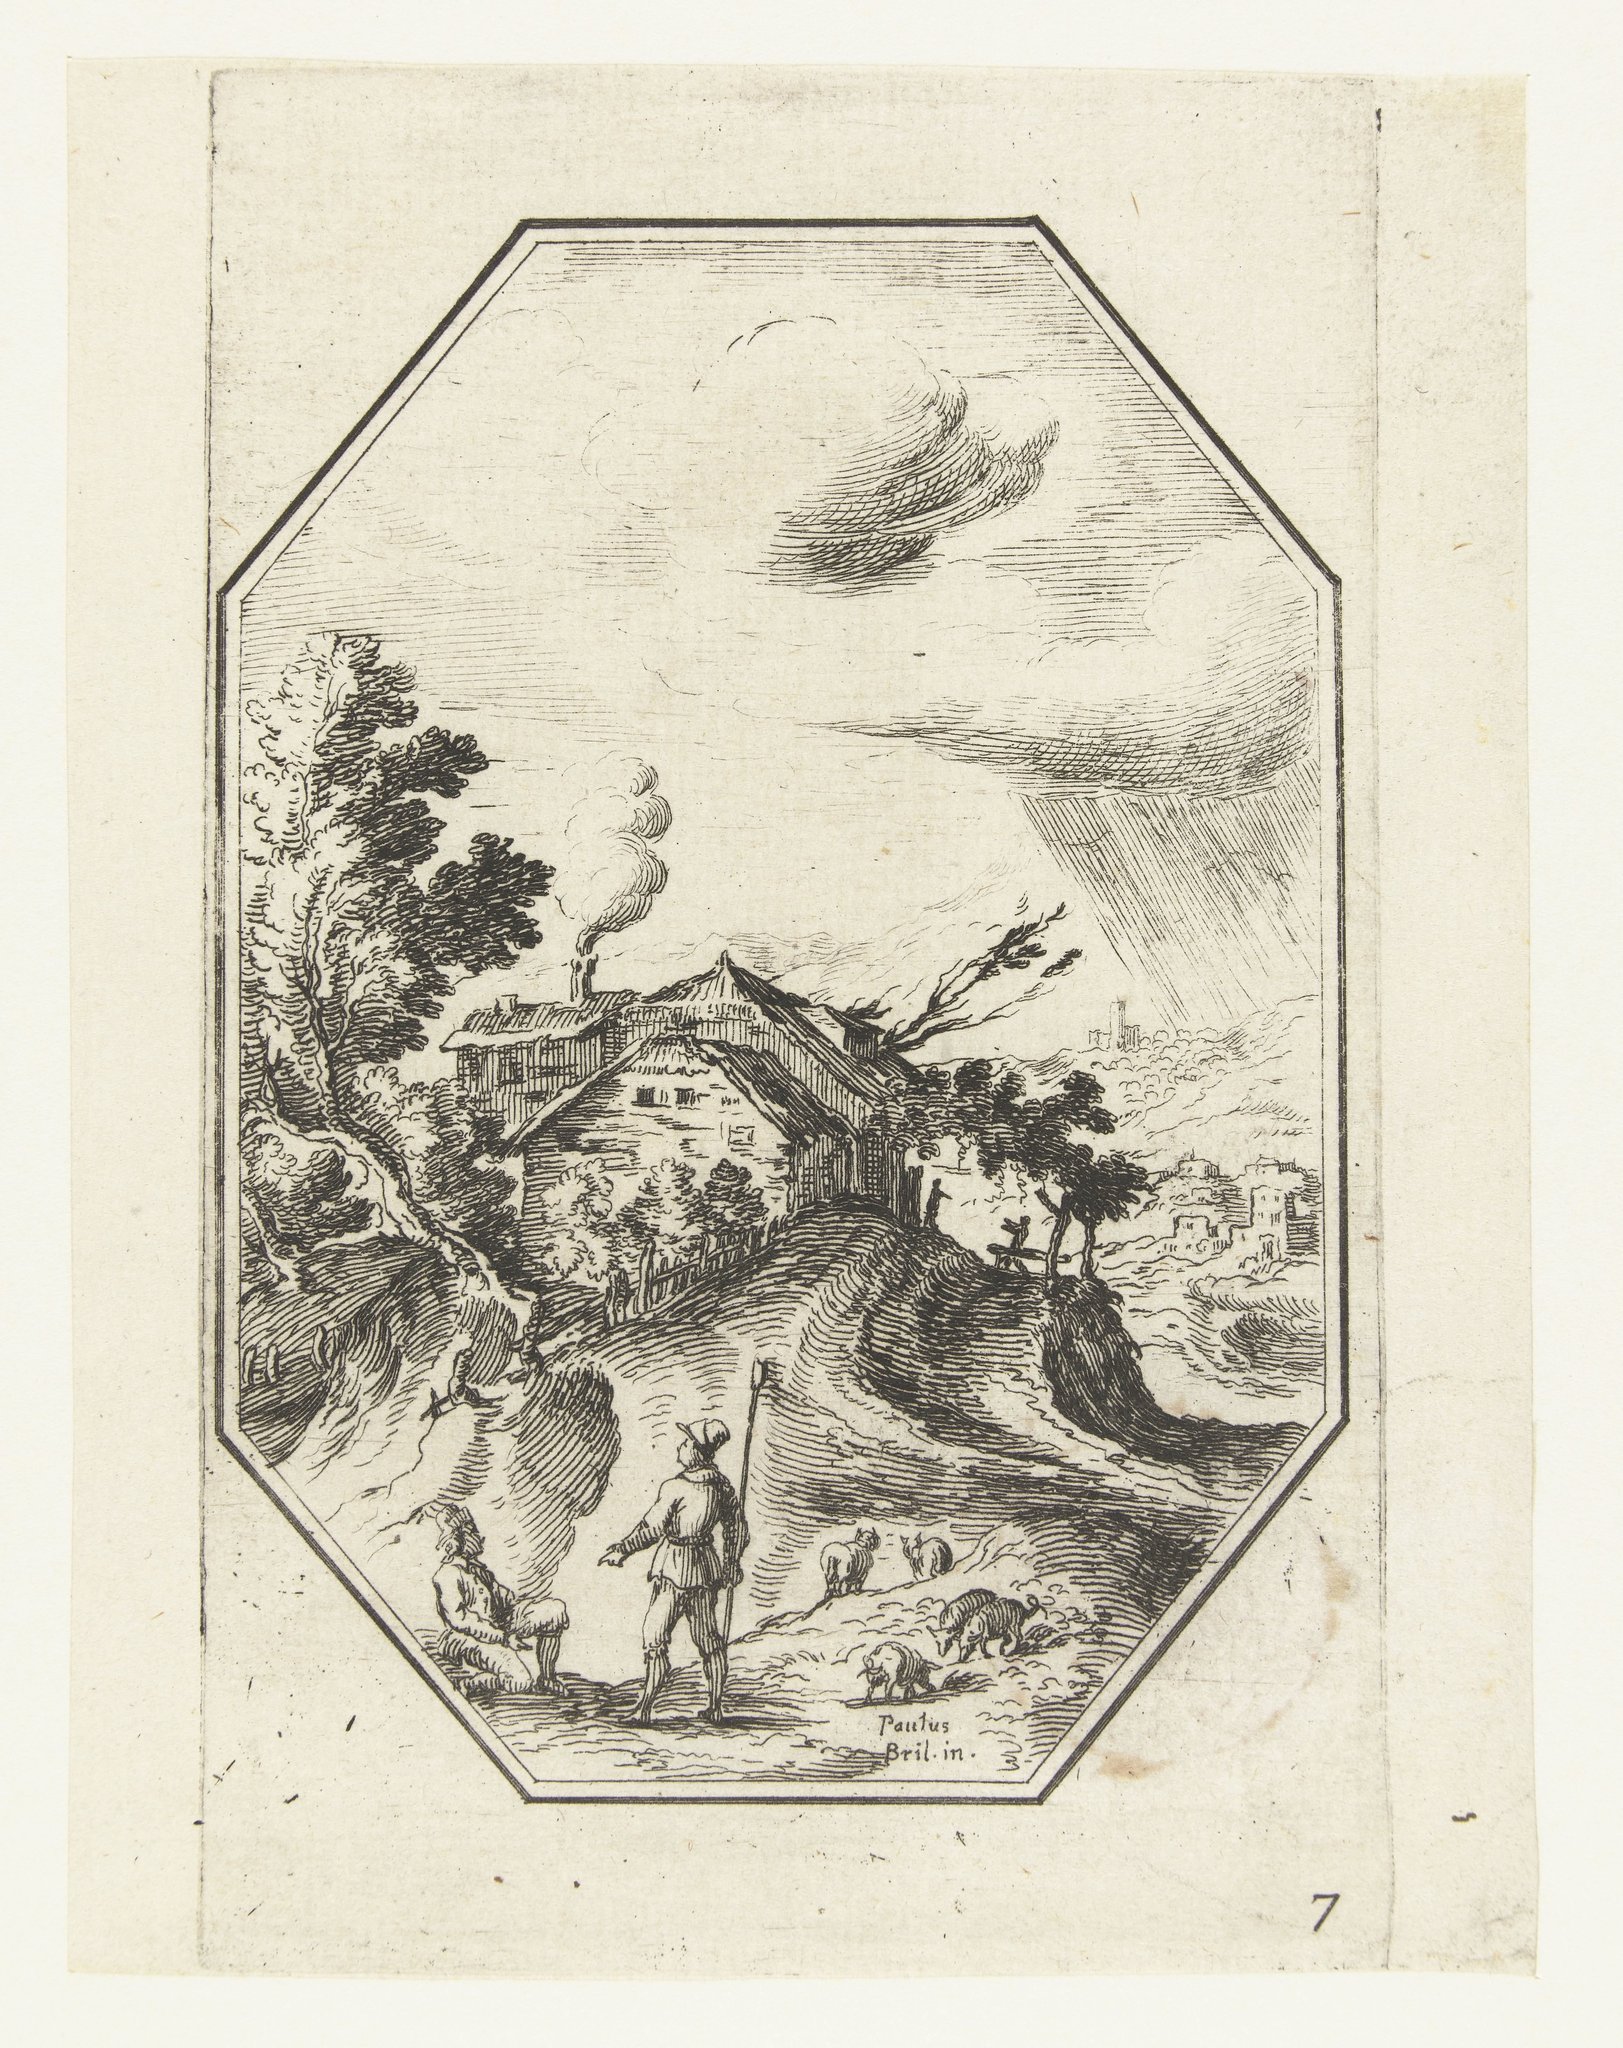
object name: kopie naar prent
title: Landschap met herder in octagonaal kader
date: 1582-1700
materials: paper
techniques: etching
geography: rome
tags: herding, herdsman, herdswoman, shepherd, shepherdess, cowherd, etc., (high) hill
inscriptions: collector's mark: Lugt 240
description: Landschap met herder in octagonaal kader, kopie naar prent van Paul Bril met landschap spiegelverkeerd weergegeven.